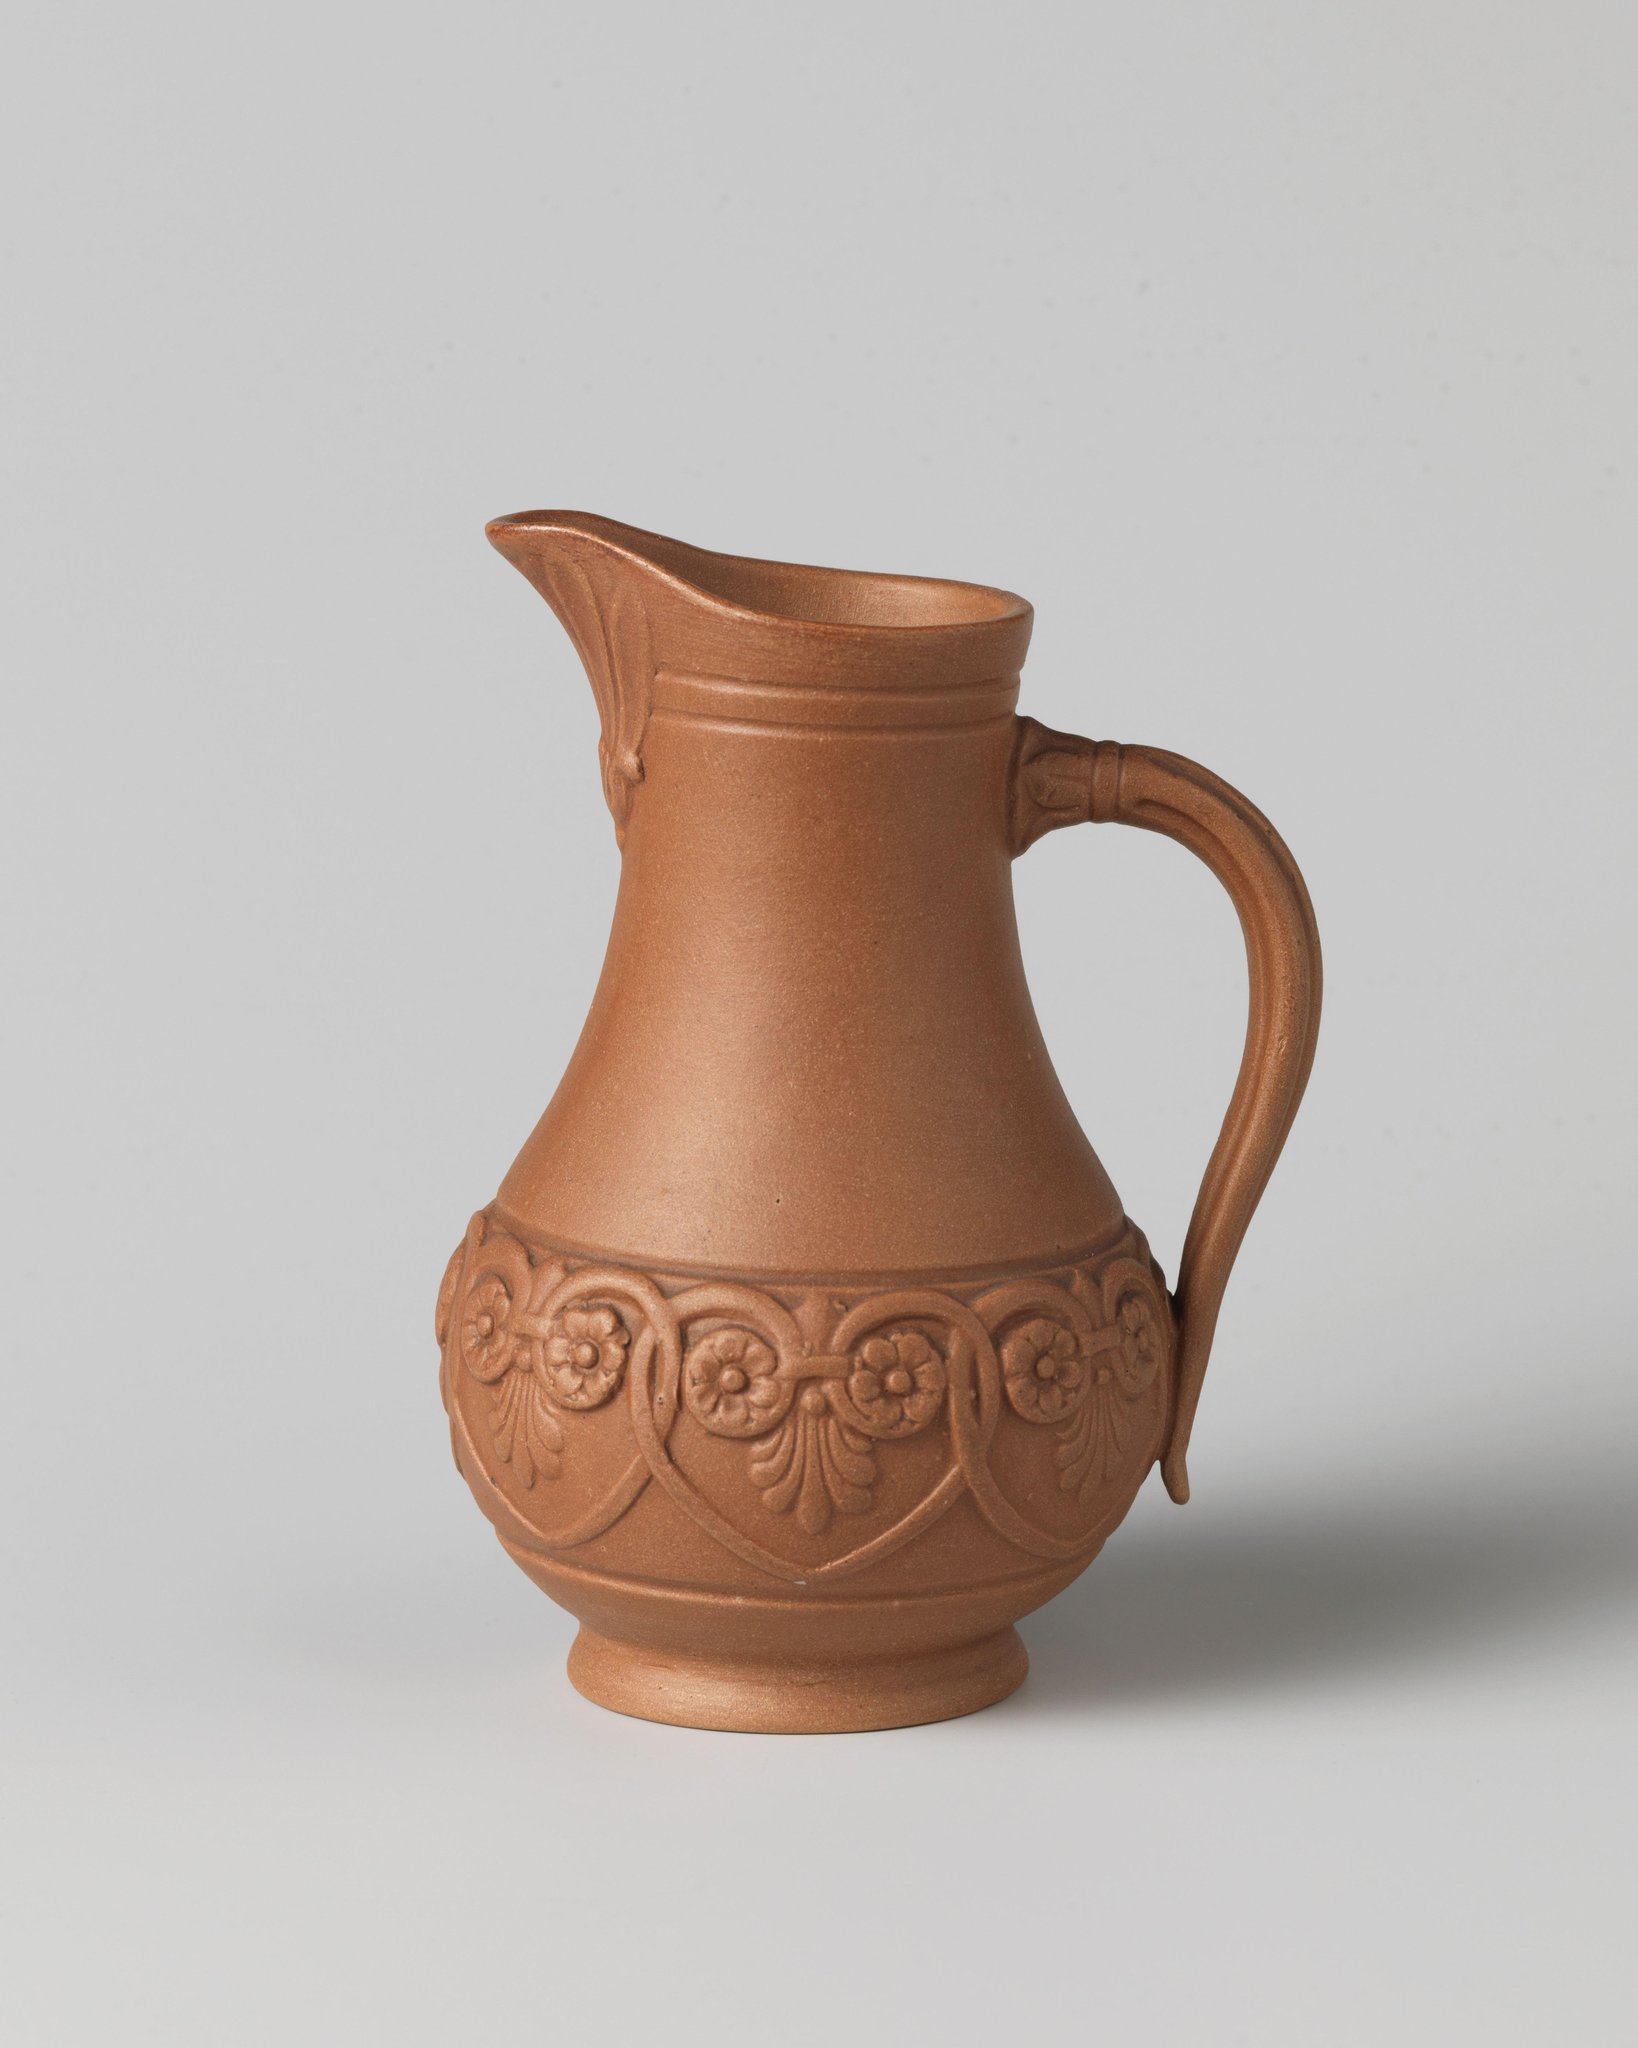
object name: ewer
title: Kan van rood hardgebakken aardewerk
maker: Anonymous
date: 1870-1915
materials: earthenware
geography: germany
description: Peervormige kan van rood hardgebakken aardewerk. De kan heeft een tuit en een gecanneleerd oor. De buik is in reliëf versierd met palmetten, geflankeerd door rozetten, waarvan de stengels een spitsboogvormige omlijsting vormen. Onder de tuit is een palmet in reliëf aangebracht. De kan is gemerkt.